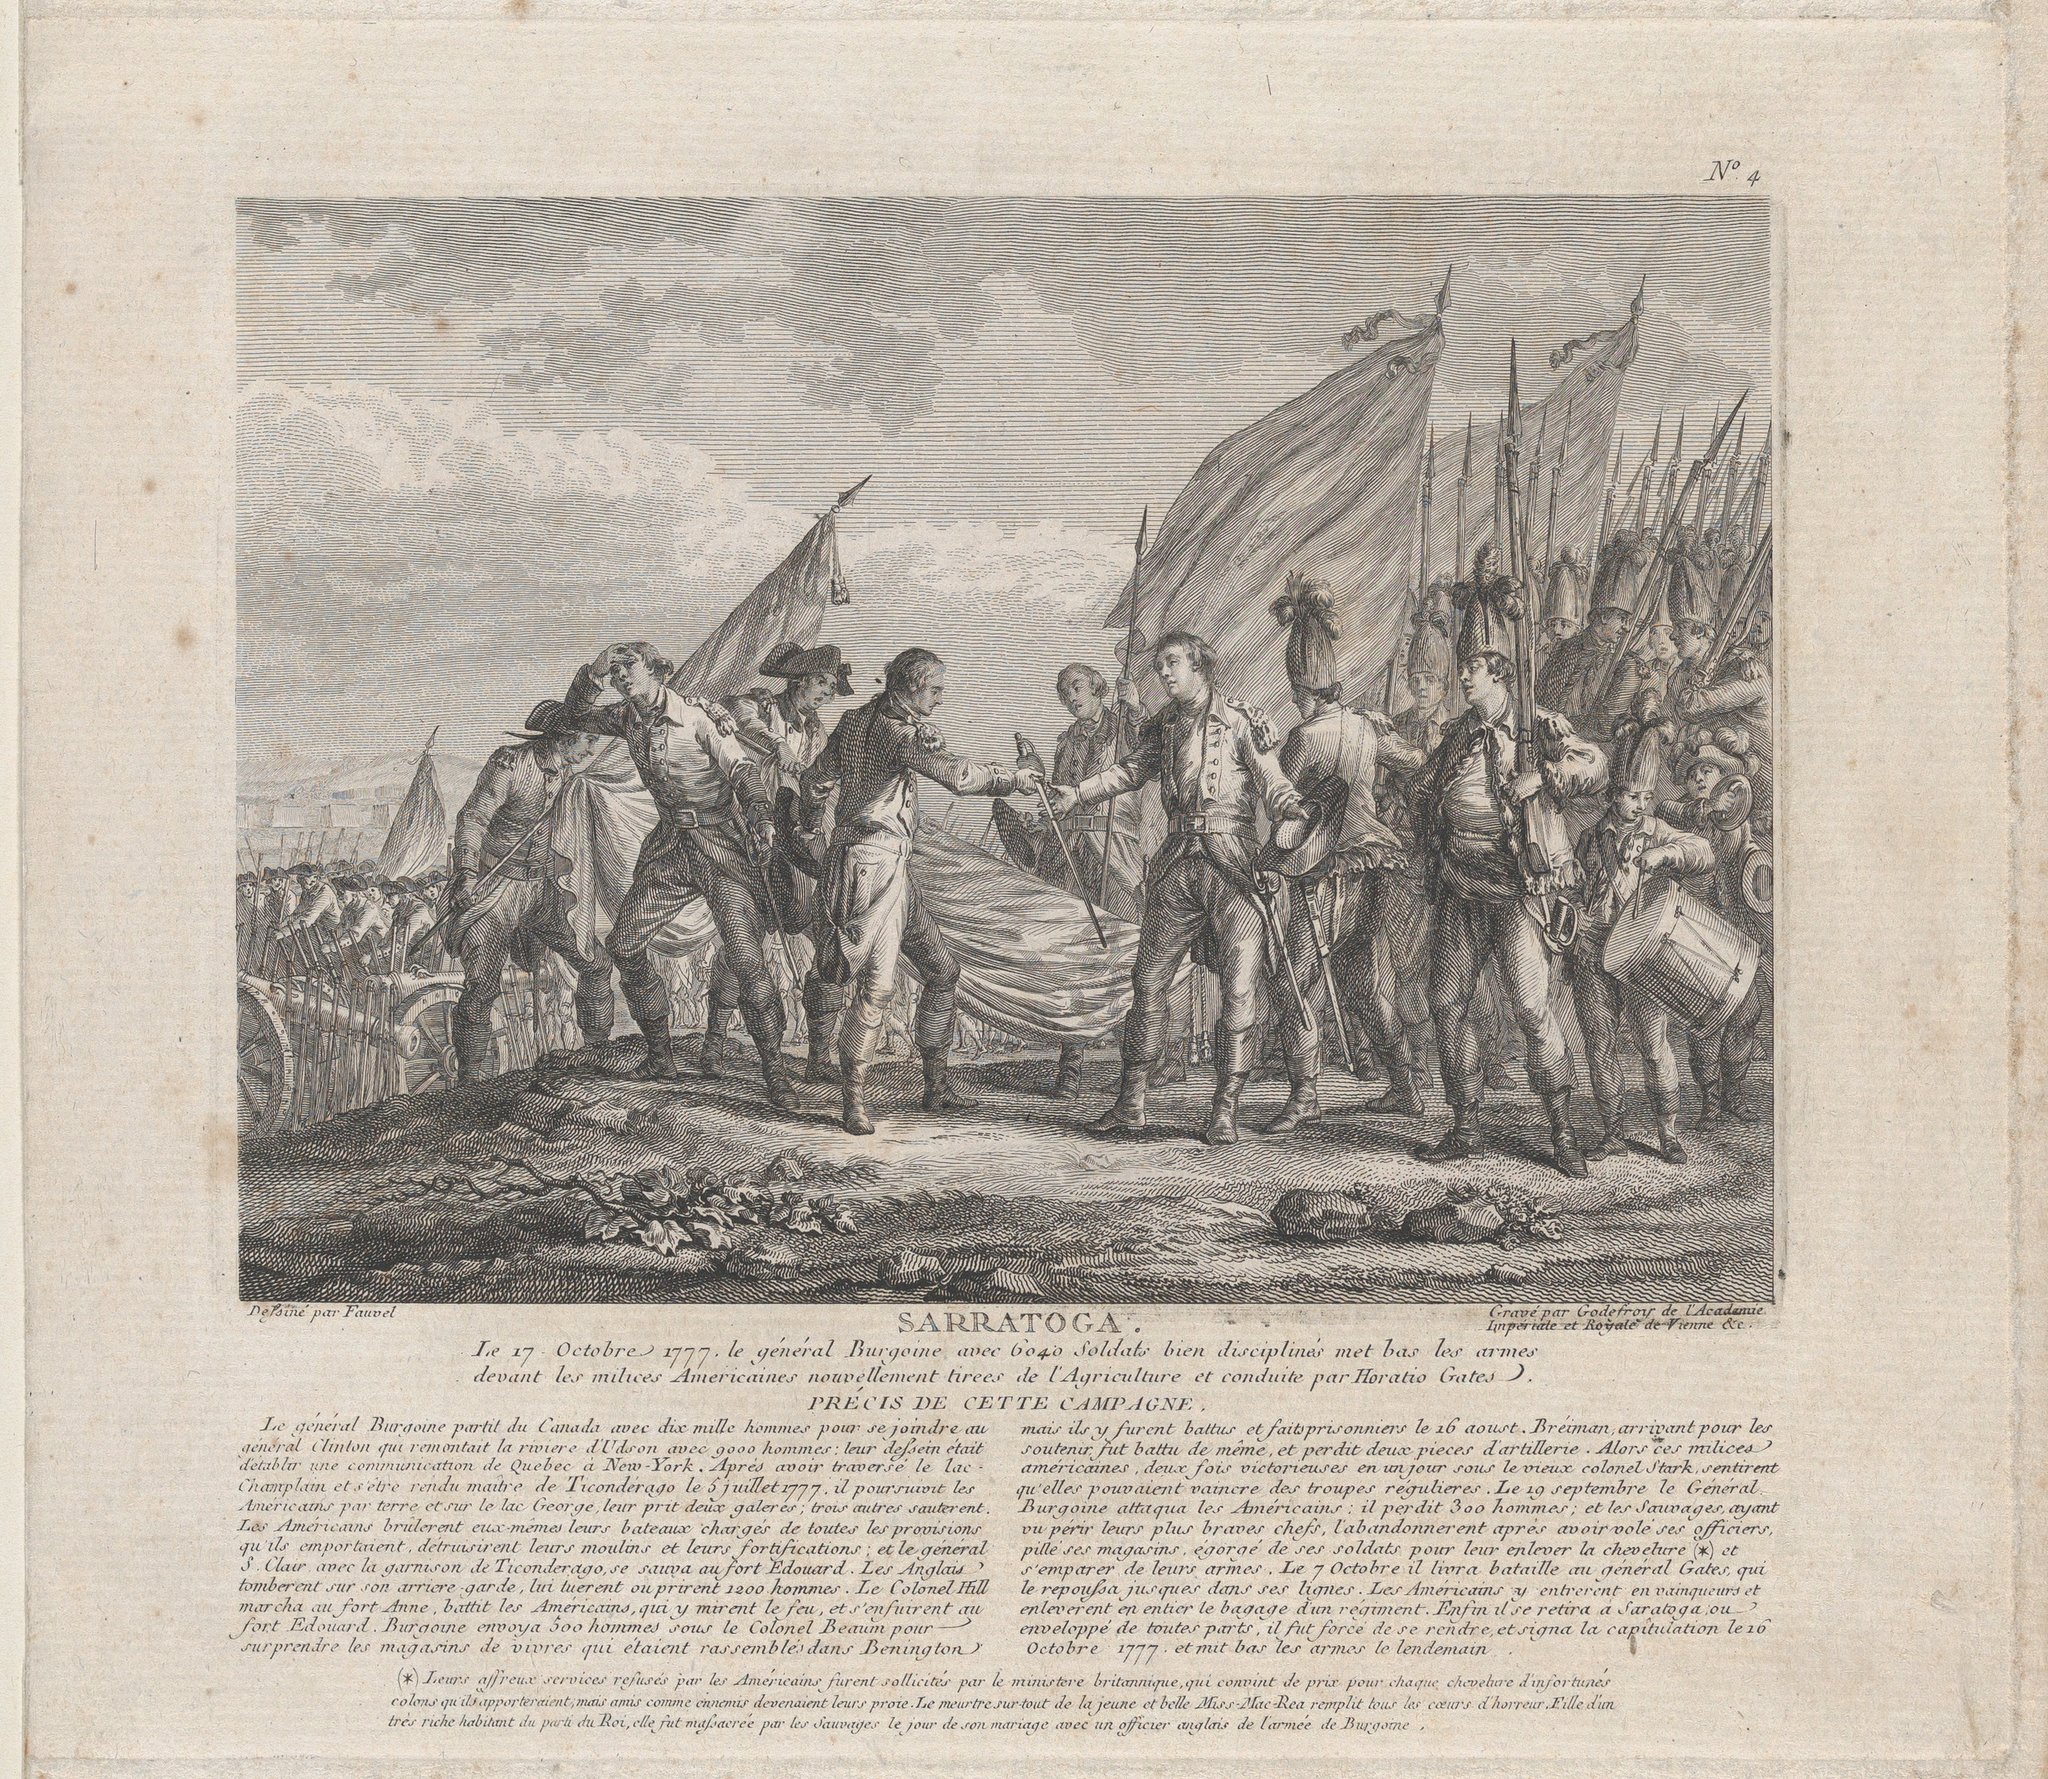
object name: print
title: Sarratoga [sic] (The Surrender of General Burgoyne to General Horatio Gates, Battle of Saratoga, October 17, 1777)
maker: françois godefroy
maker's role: engraver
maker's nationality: french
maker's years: 1743-1819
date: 1784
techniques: engraving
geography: france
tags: battles,soldiers,firearms,flags